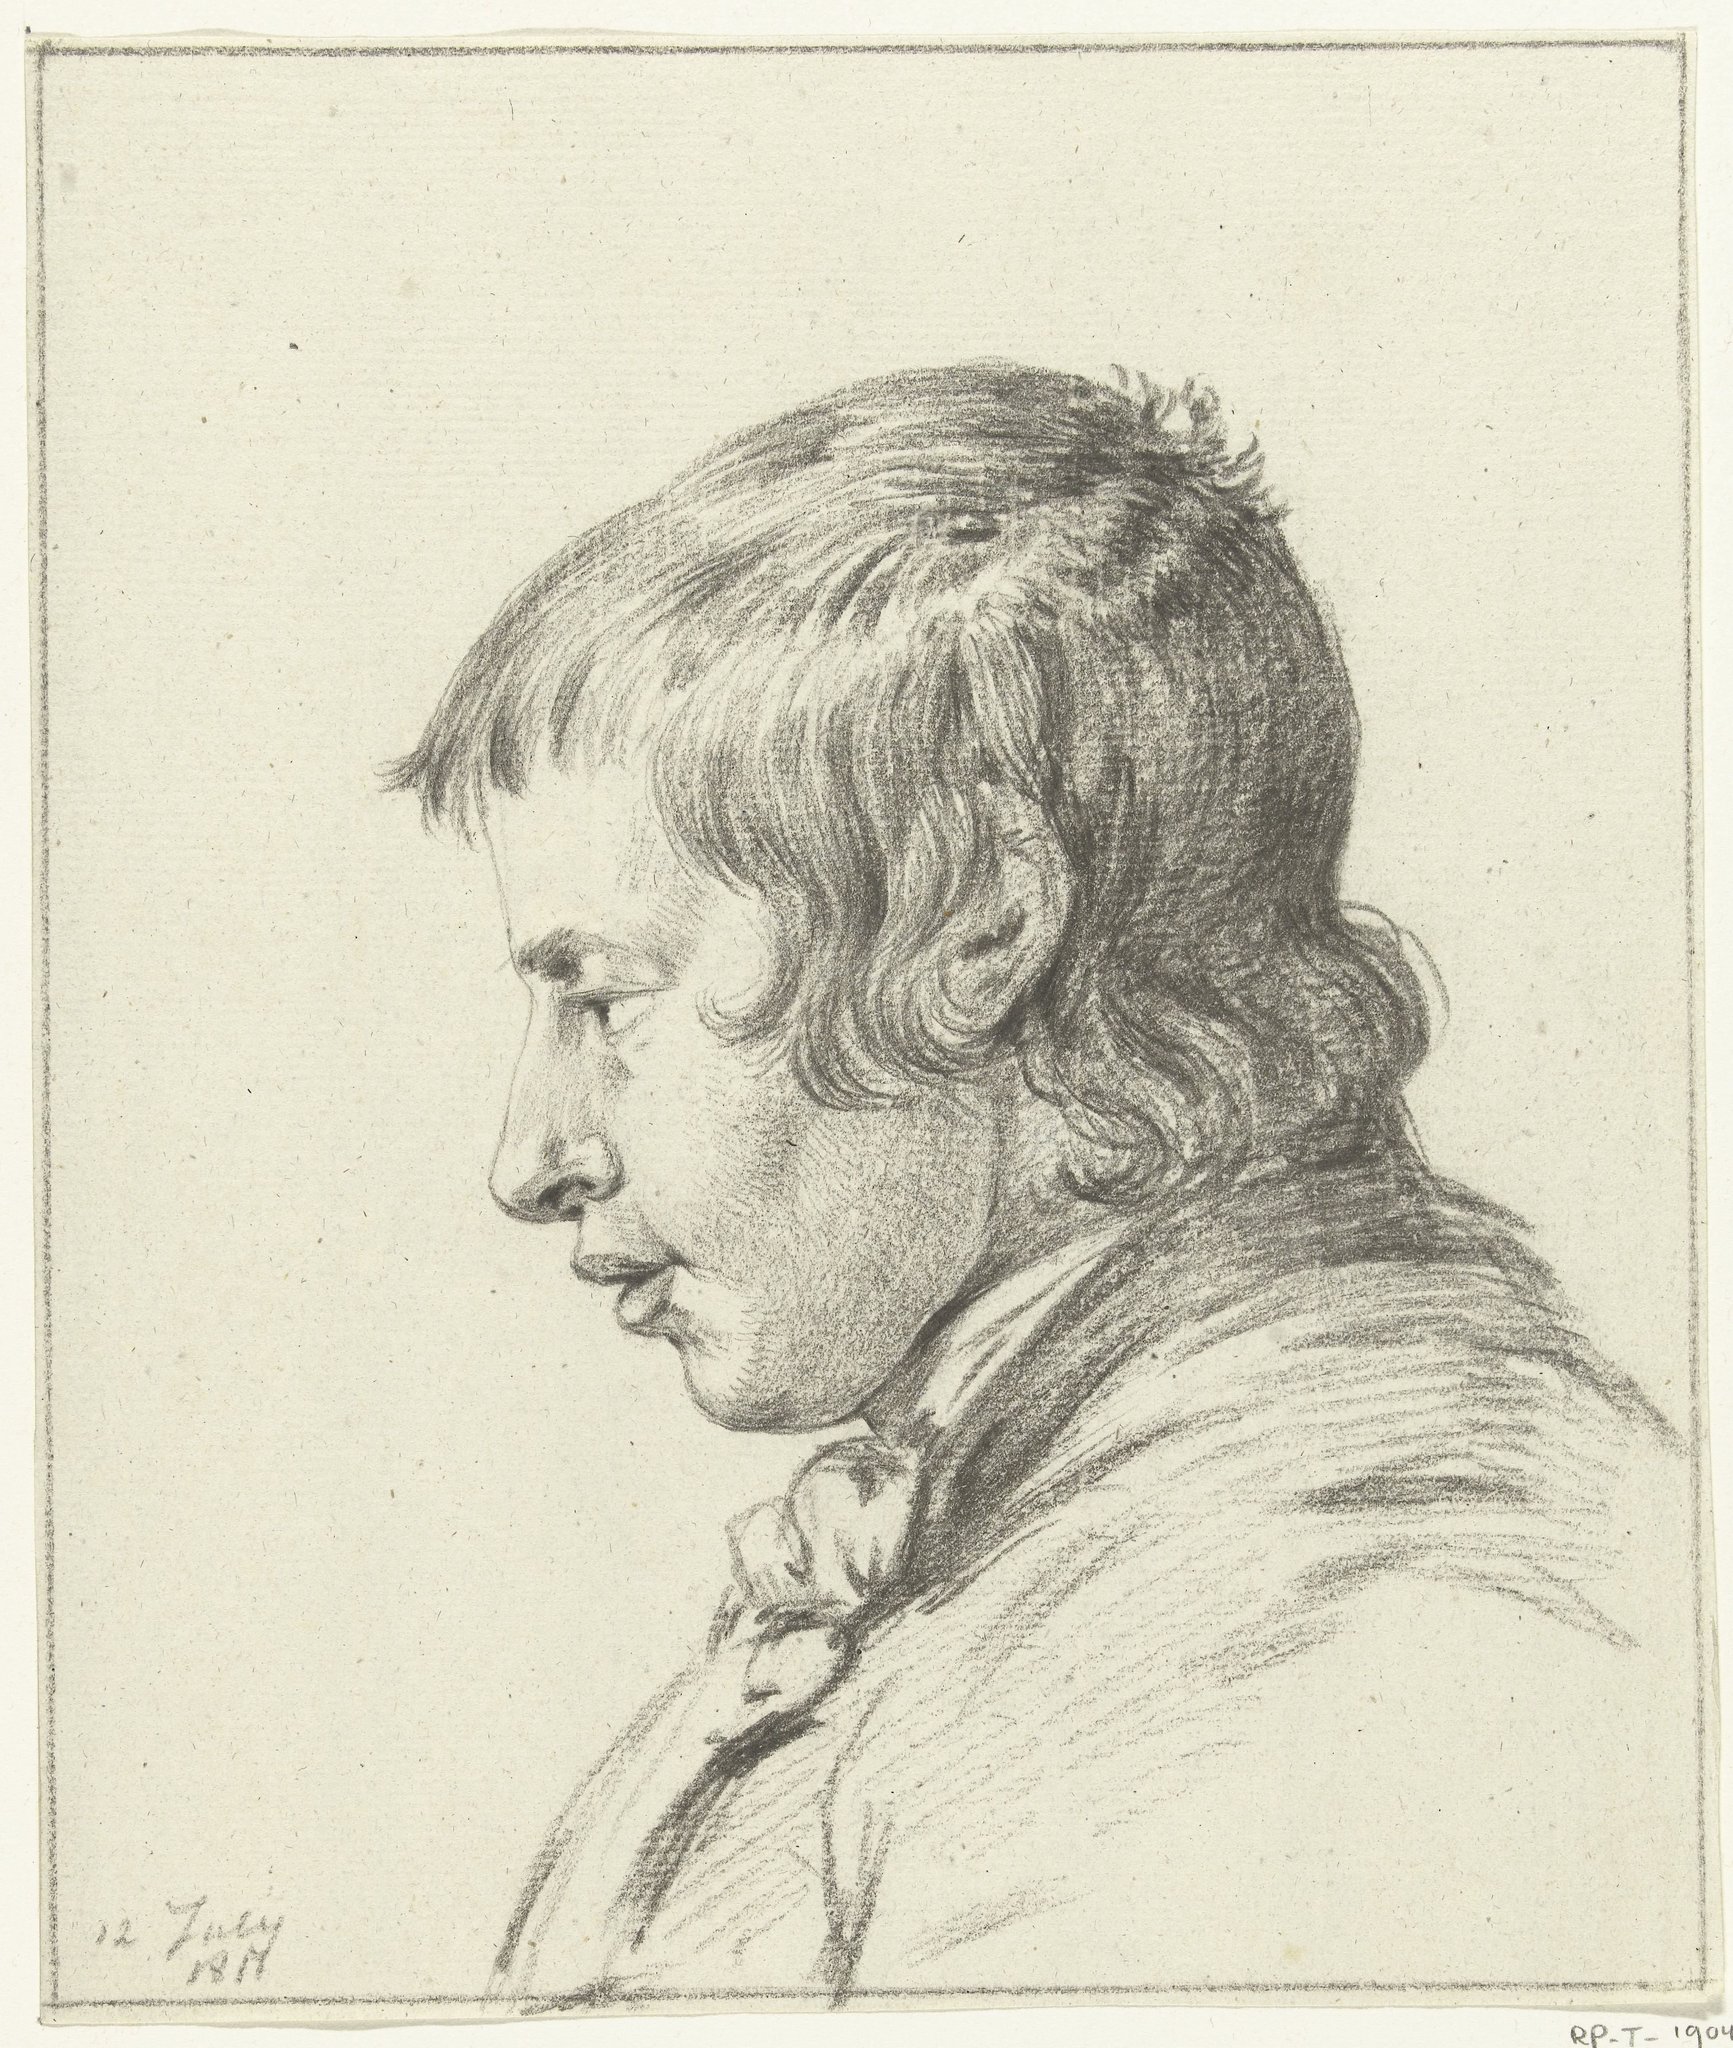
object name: drawing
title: Kop van een jongen, naar links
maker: jean bernard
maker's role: draughtsman, print maker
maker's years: 1765-1833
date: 1811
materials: chalk, paper, pencil